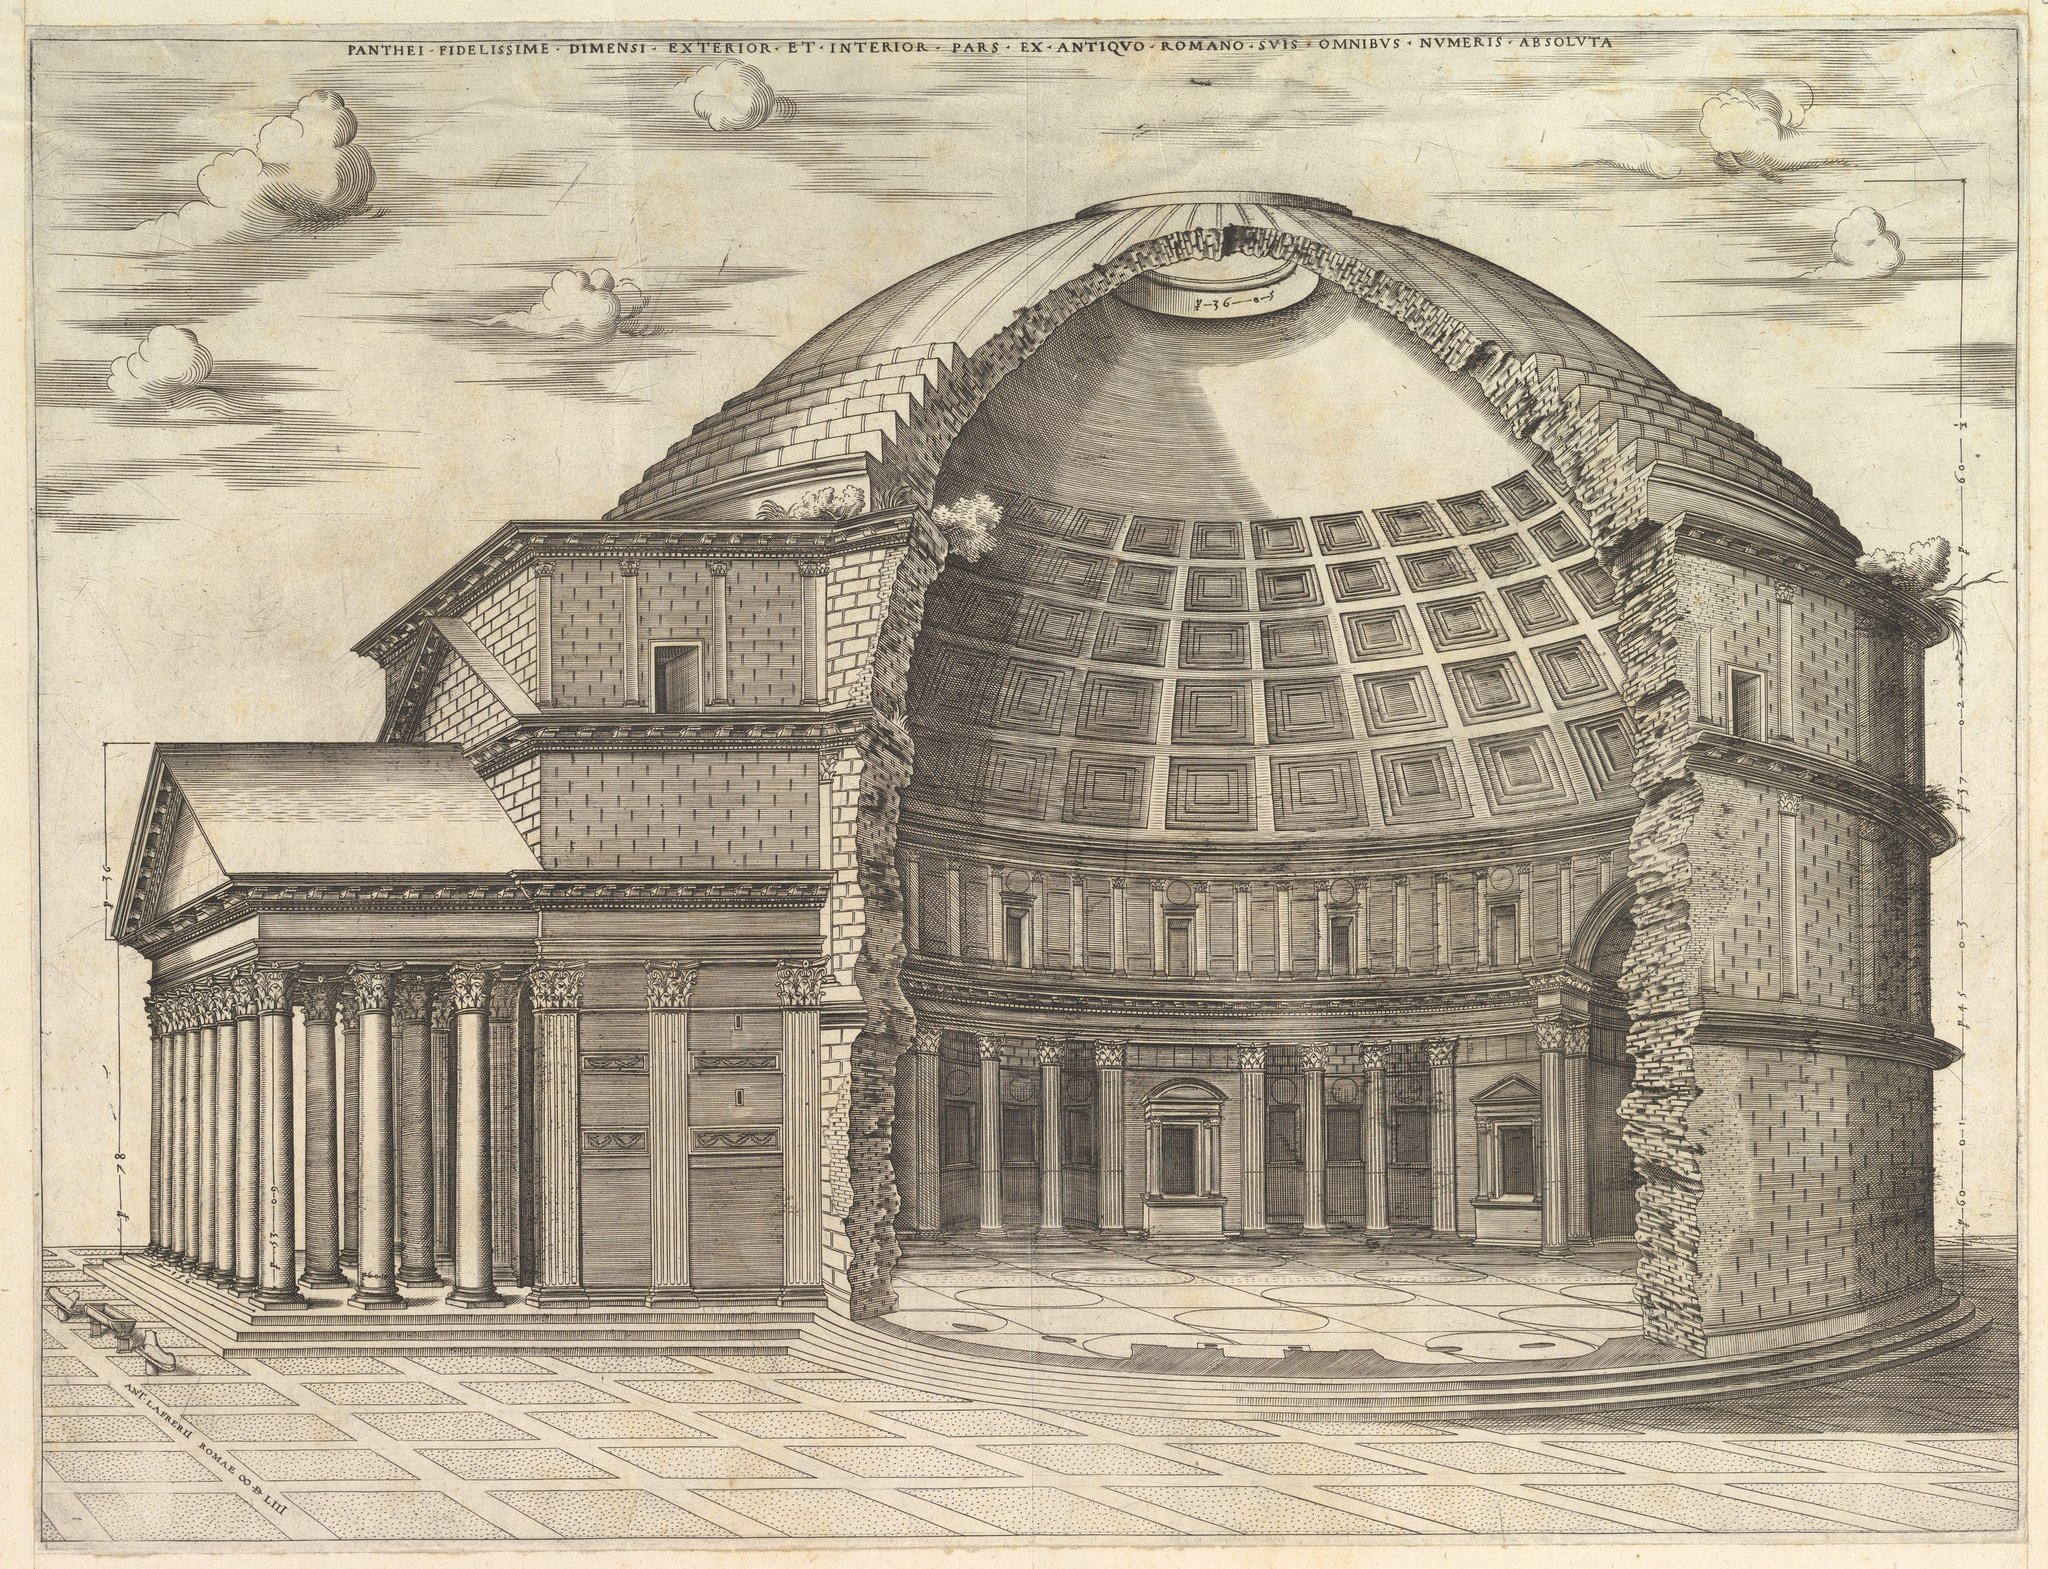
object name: print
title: The Pantheon, broken away to show the interior, from "Speculum Romanae Magnificentiae"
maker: Anonymous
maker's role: artist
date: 1553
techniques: engraving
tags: architecture,rome